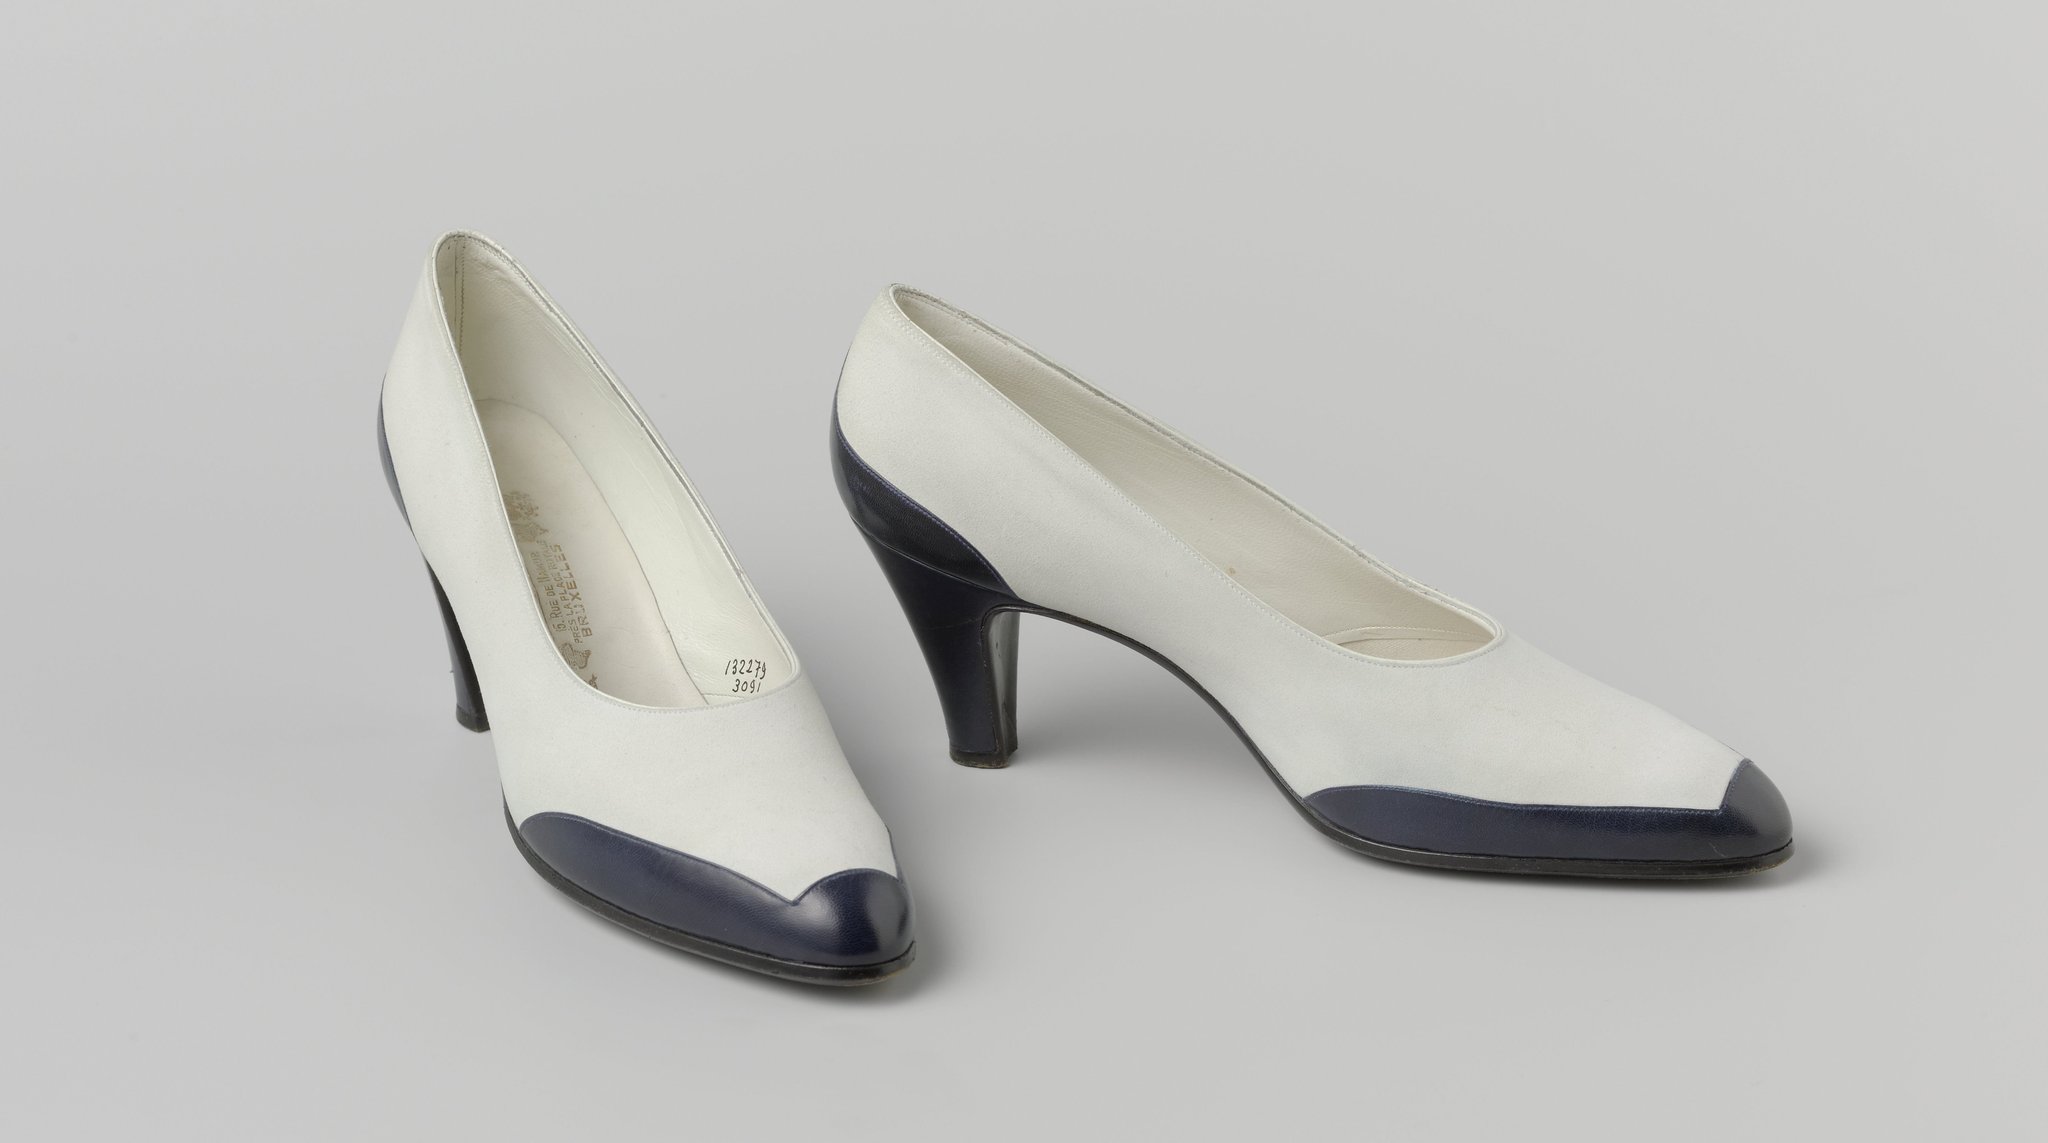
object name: pump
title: Pump van wit wasleer versierd met marineblauw kalfs(?)leer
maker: a. van goethem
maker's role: schoenmaker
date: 1950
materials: leather, cotton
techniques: tanning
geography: brussels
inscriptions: customer number: ‘132279/3091’, last number: ‘132279/3091’, address: ‘A. van Goethem/ 15, Rue de Namur/ près la Place Royale/ Bruxelles’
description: Linkerpump van wit wasleer versierd met marineblauw kalfs(?)leer. Model: uit één stuk wasleer met een achternaad. Hoge (7 cm) rechte hak. De voorvoet is gevoerd met naturelkleurig katoen; de rest van de schoen met wit kalfs(?)leer. Beige leren binnenzool met gouden opdruk. Versiering: over de neus een extra neusstuk (2.5 cm) van marineblauw leer dat aan weerskanten halfrond doorloopt. Op de hiel een vleugel van marineblauw leer die overgaat in de blauwe hak. Adres (op de binnenzool): A.VAN GOETHEM 15.RUE DE NAMUR/PRES LA PLACE ROYALE/BRUXELLES. Opmerking: in de linker- en rechterschoen is met inkt geschreven: 132279/3091.